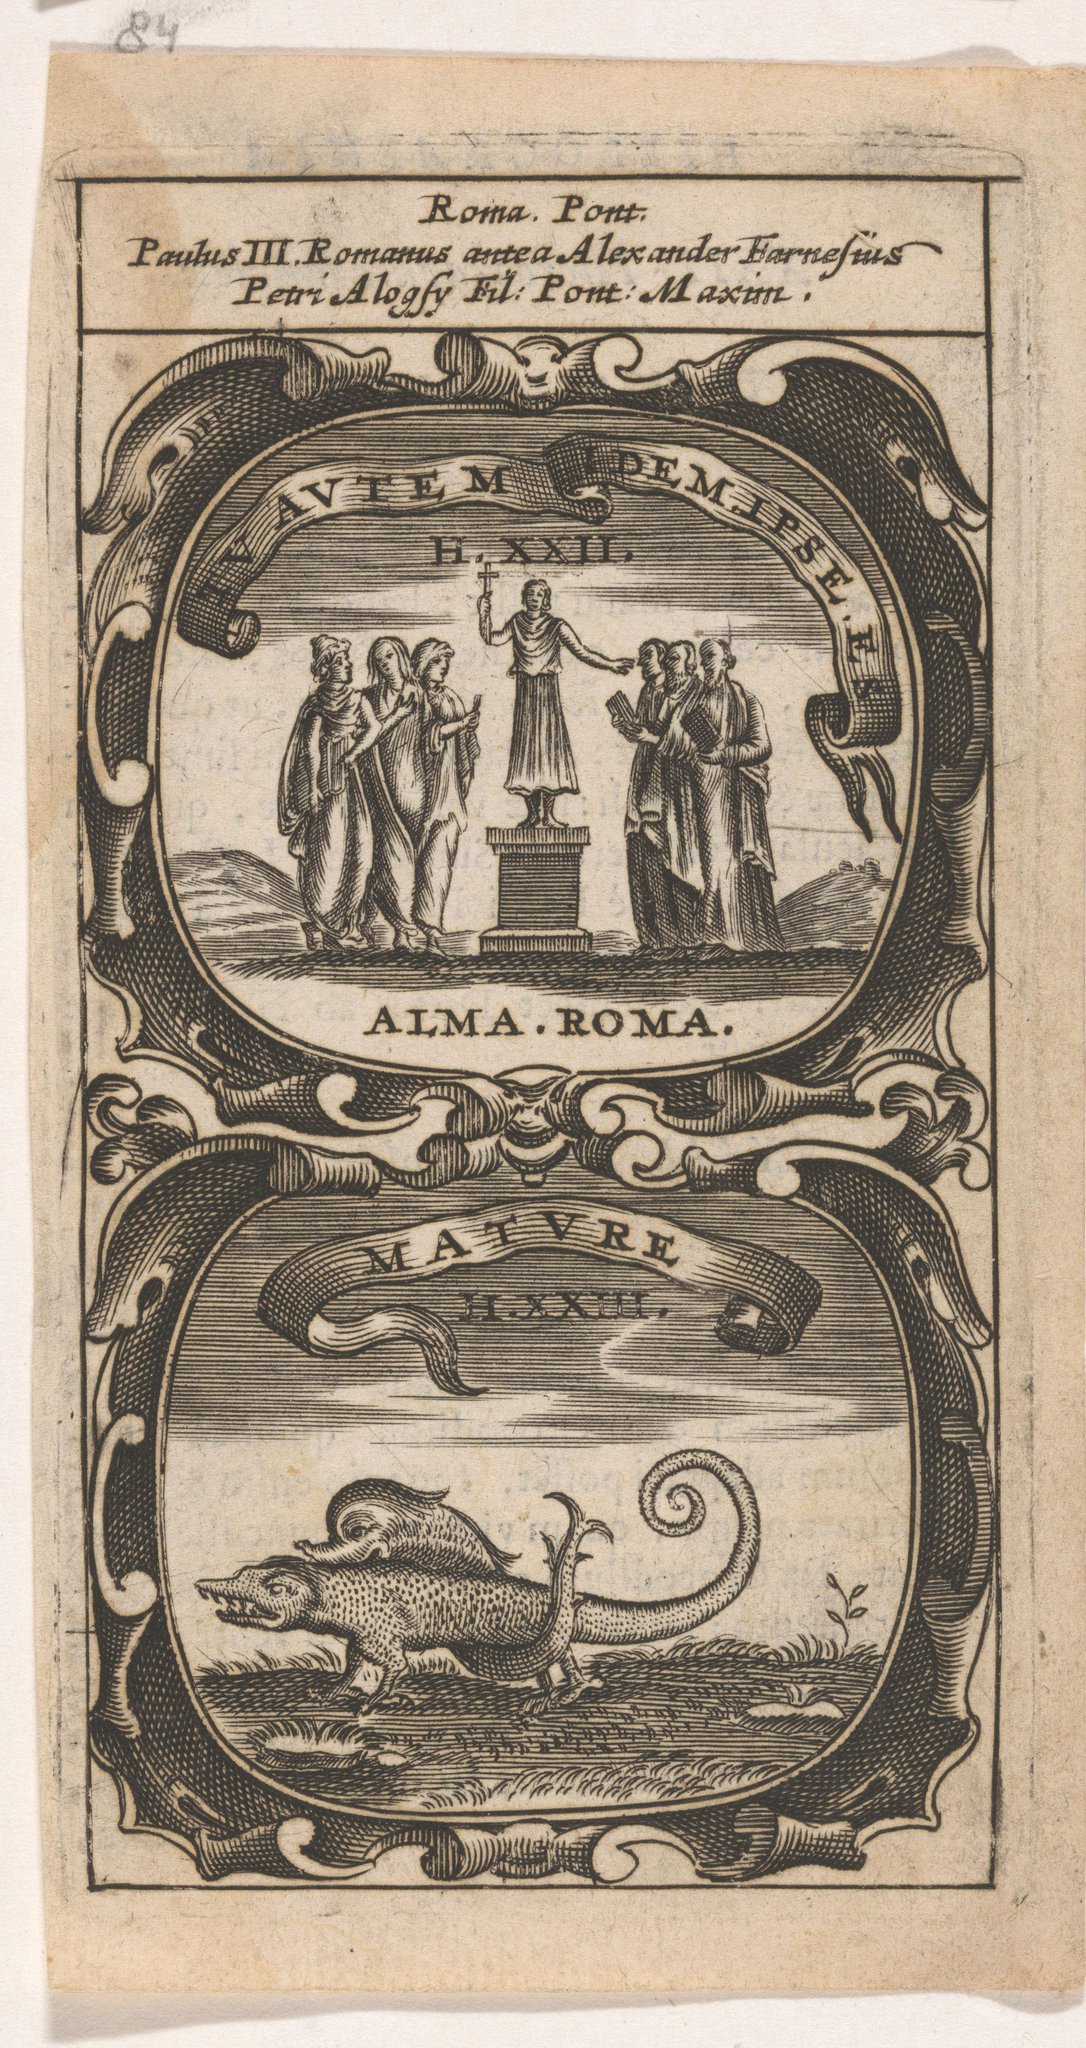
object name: book illustration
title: Symbola Divina et Humana Pontificum Imperatorum Regum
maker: Anonymous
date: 1666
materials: paper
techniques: engraving, letterpress printing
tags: rome, priest, paulus iii, swimming mammals: dolphin, lizards: chameleon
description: Pagina uit Jacob Typotius, Symbola Divina & Humana Pontificum Imperatorum Regum. Arnhem, J.F. Hagen, 1666 of uit de titeluitgave van 1669 of 1679. Het werk van Typotius werd voor het eerst uitgegeven in 1601 met prenten van Aegidius Sadeler.